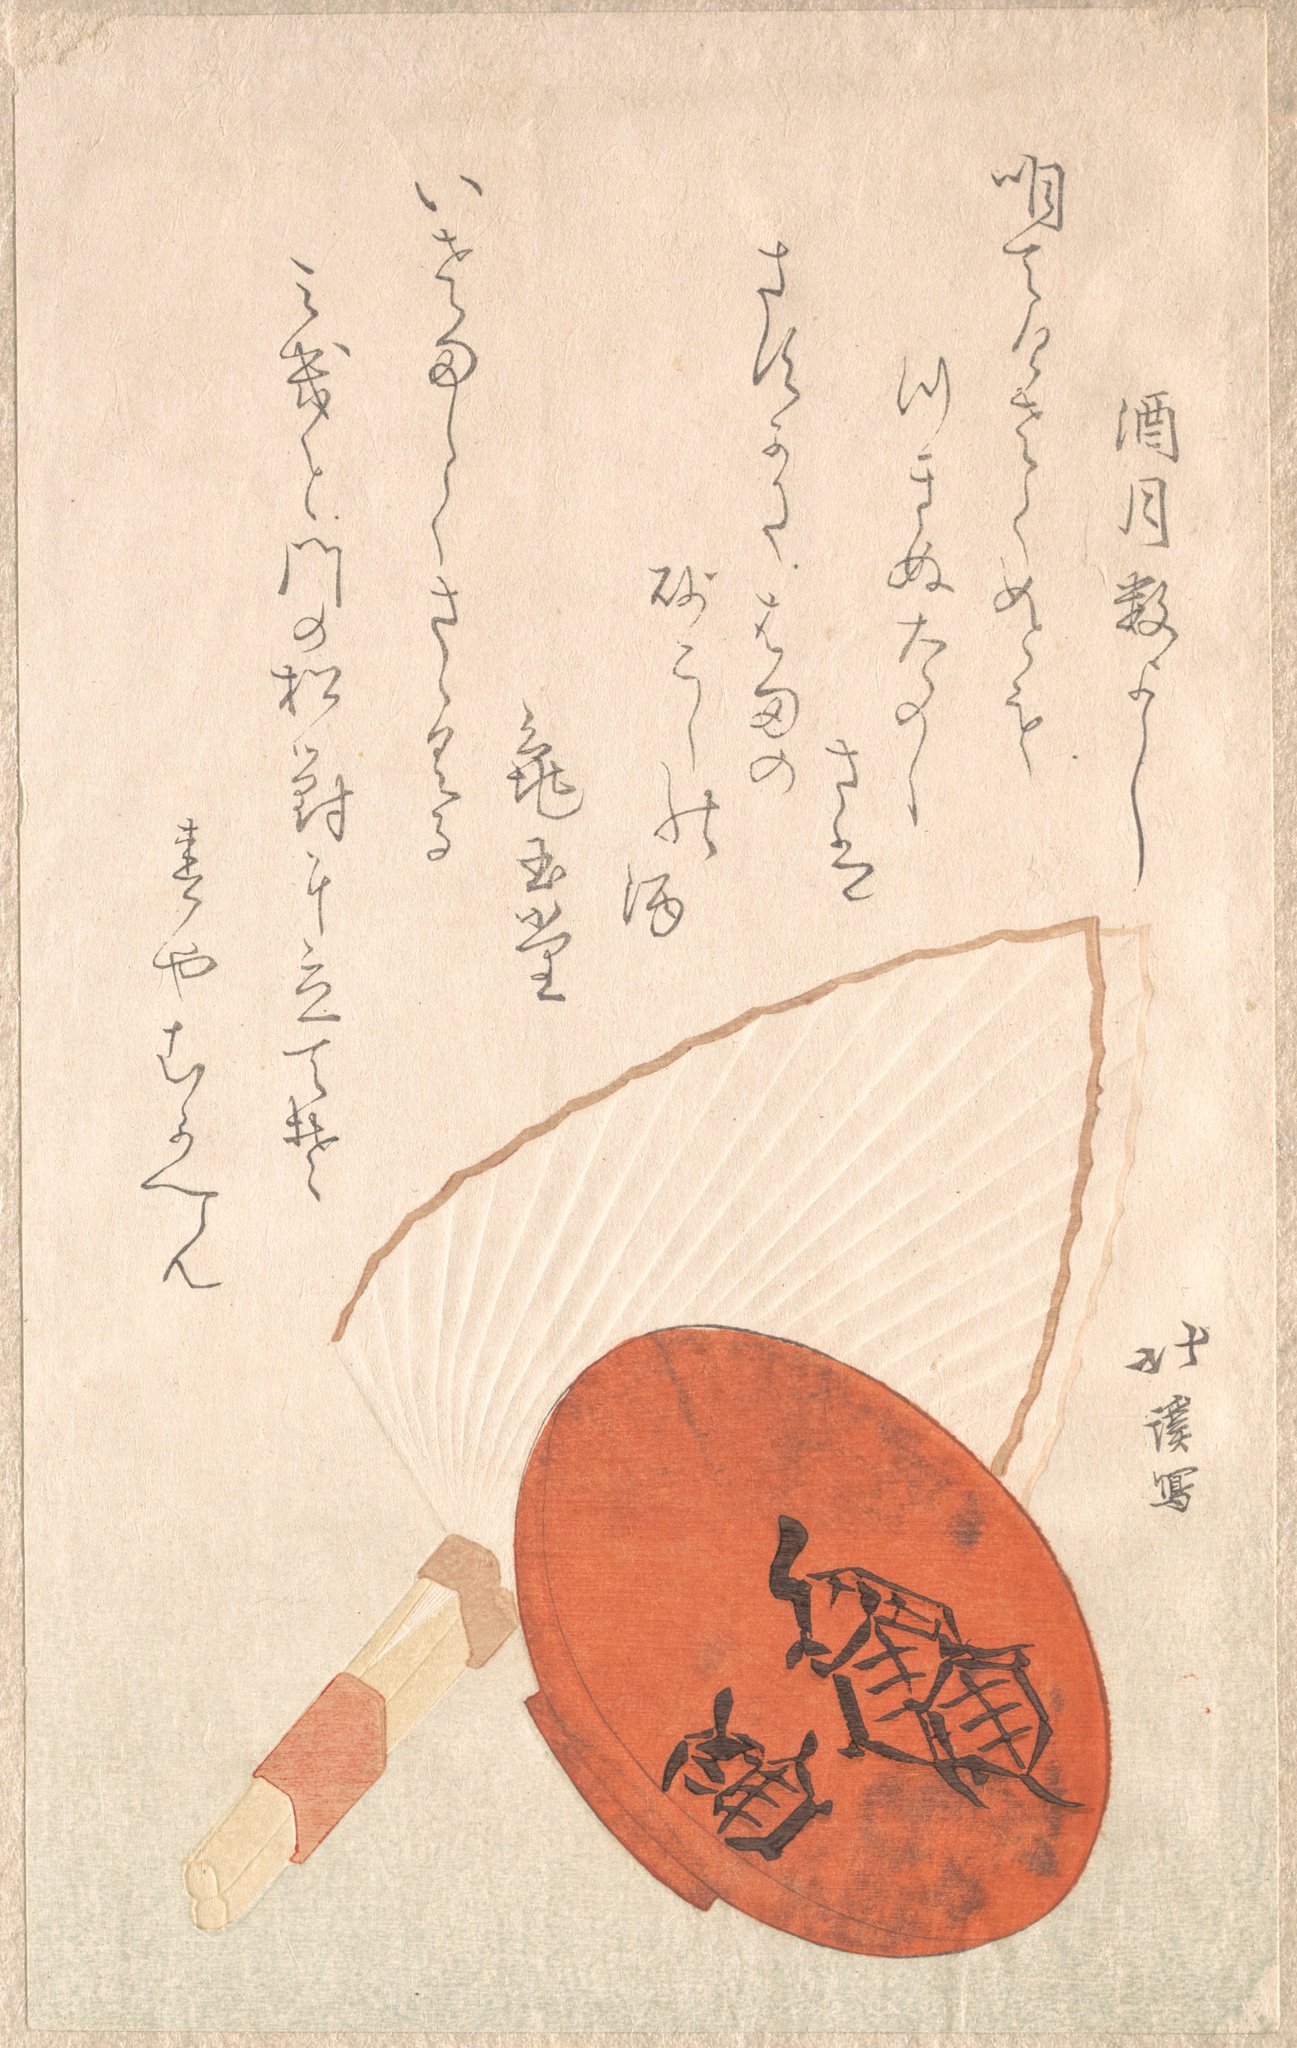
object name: print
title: Wine-Cup and Fan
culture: japanese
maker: totoya hokkei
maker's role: artist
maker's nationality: japanese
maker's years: 1780-1850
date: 1801-1833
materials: ink, paper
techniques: surimono, woodblock print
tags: fans